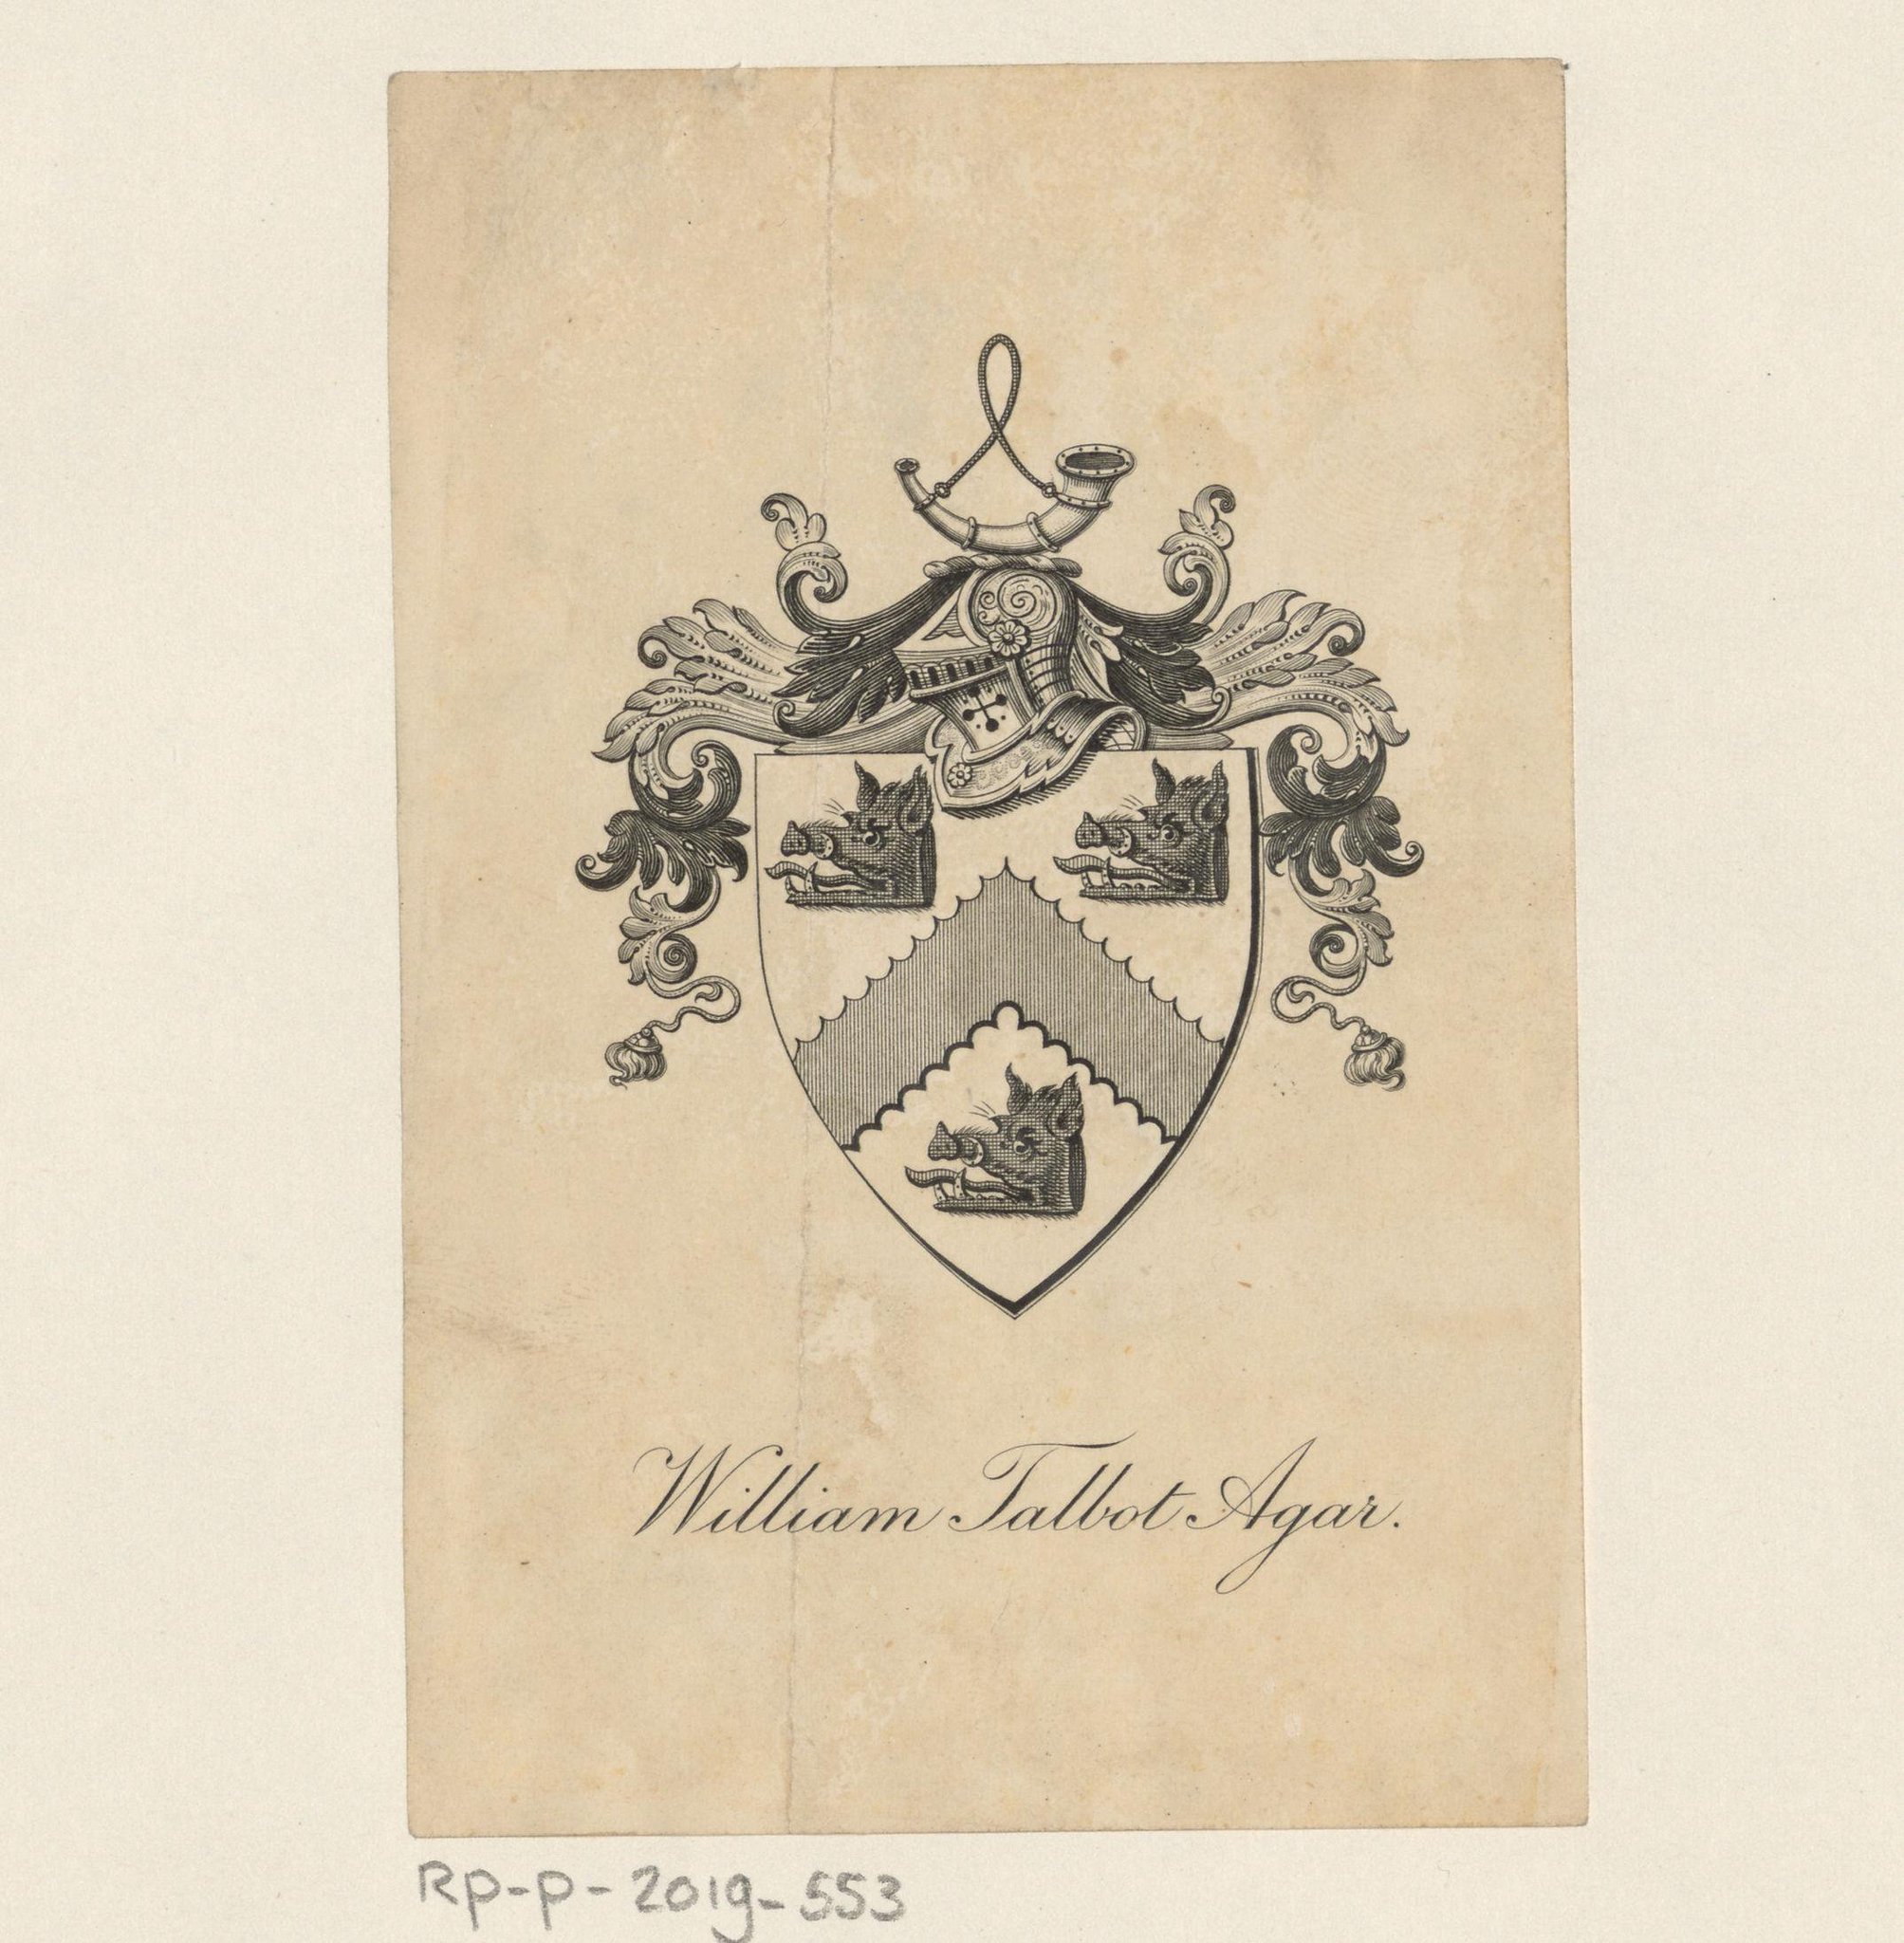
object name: bookplate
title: Ex libris van William Talbot Agar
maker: Anonymous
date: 1824-1906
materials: paper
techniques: engraving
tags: armorial bearing, heraldry